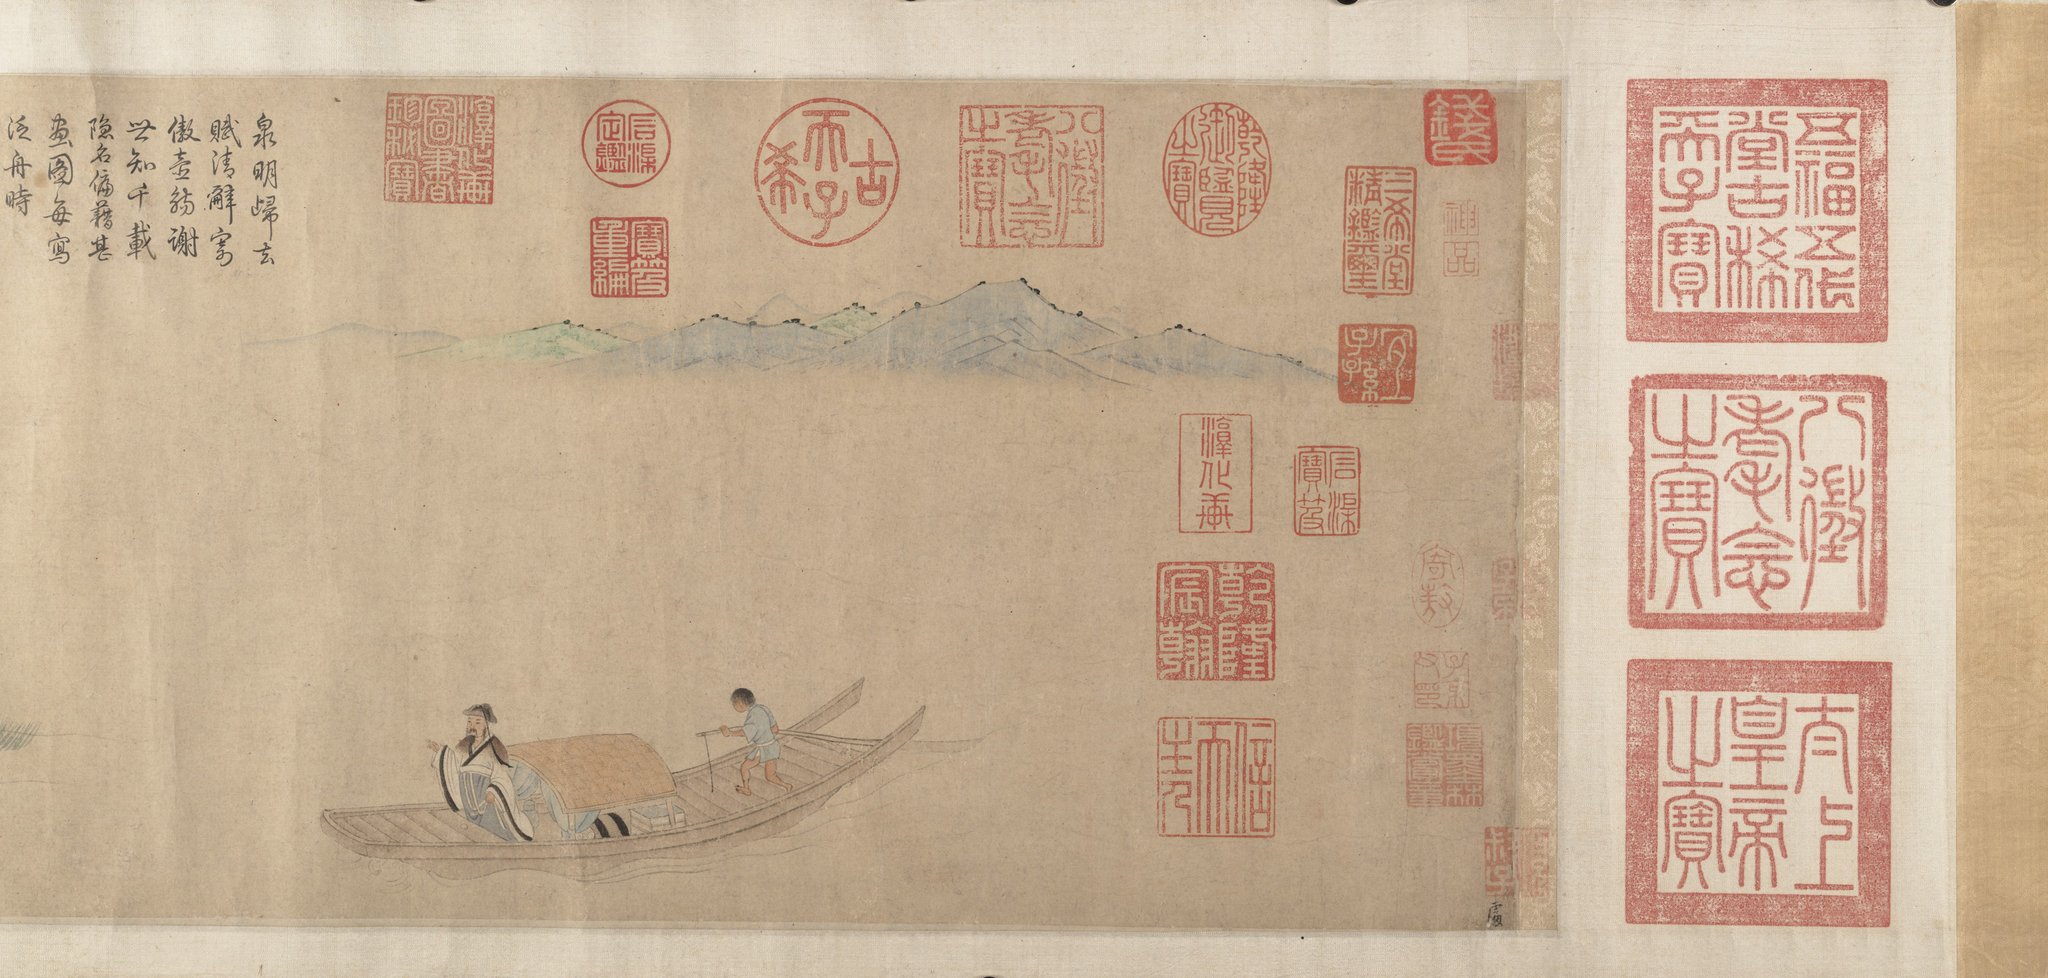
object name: handscroll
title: Ode on Returning Home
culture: chinese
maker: qian xuan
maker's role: artist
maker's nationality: chinese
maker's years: 1239-1301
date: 1301-1500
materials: gold, ink, paper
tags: men,landscapes,boats